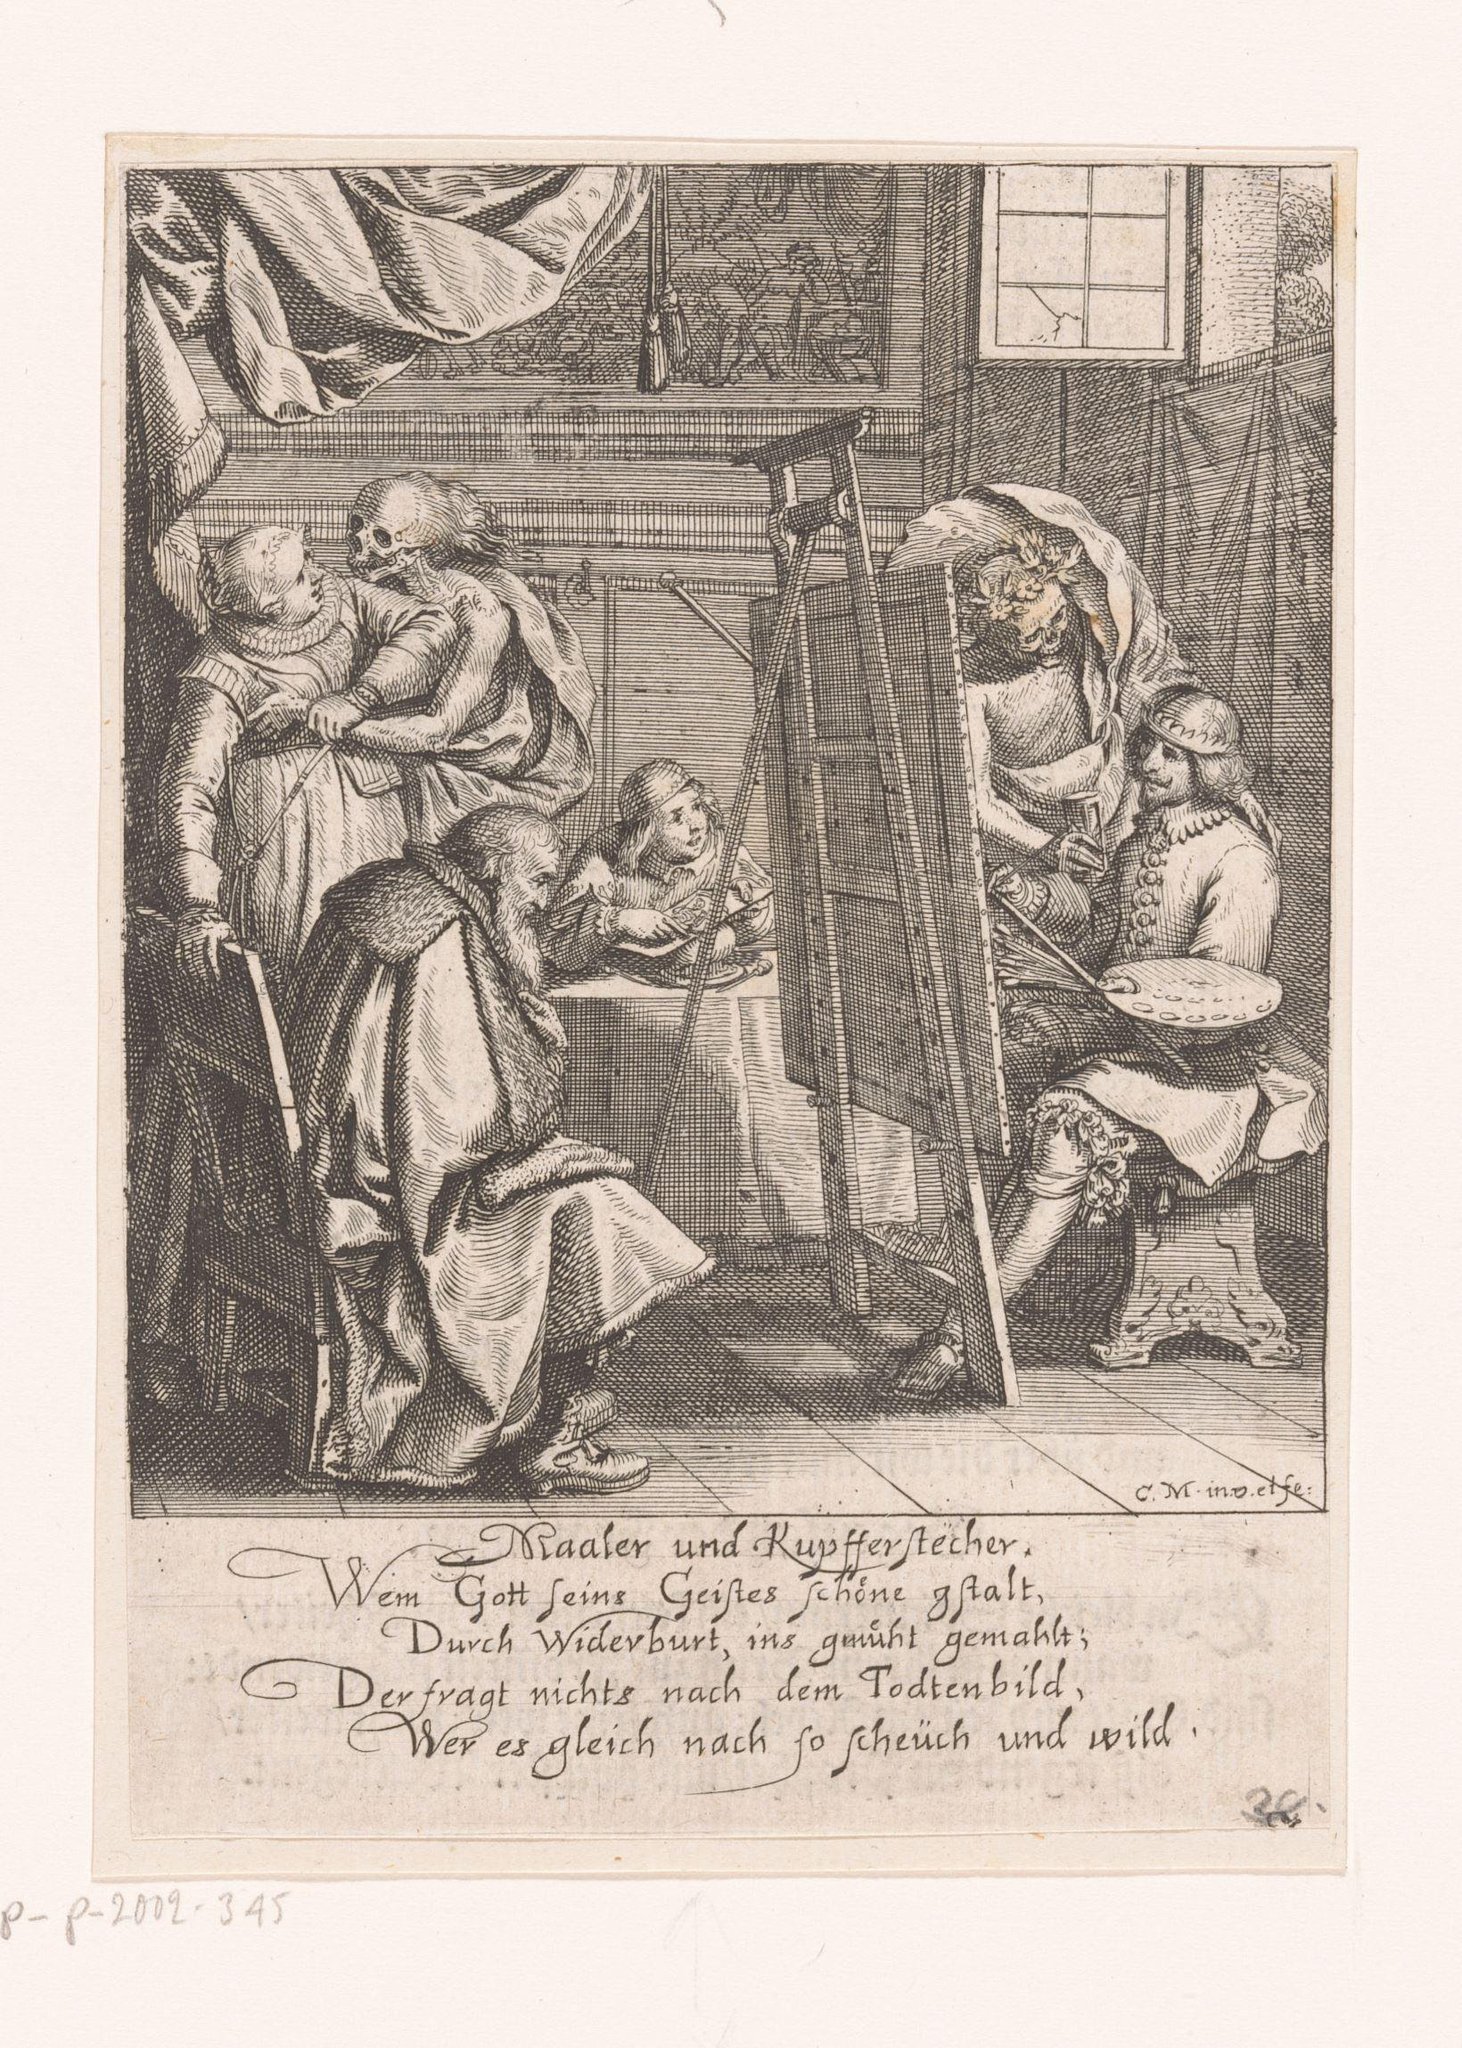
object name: book illustration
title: Schilder en graveur met de Dood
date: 1650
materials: paper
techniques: etching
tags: engraver, etcher, personifications of death; 'morte' (ripa), dance of death; death together with one or more human beings, old man, painter at work, in his studio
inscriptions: collector's mark: Lugt 2233, collector's mark: Lugt 2228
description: Een schilder in zijn atelier achter zijn ezel, het portret schilderend van een poserende oude heer. Naast de schilder de Dood met lauwerkrans op het hoofd. Tegen de achterwand zit een graveur aan een tafel te werken. Een tweede gestalte van de Dood omhelst een vrouw.